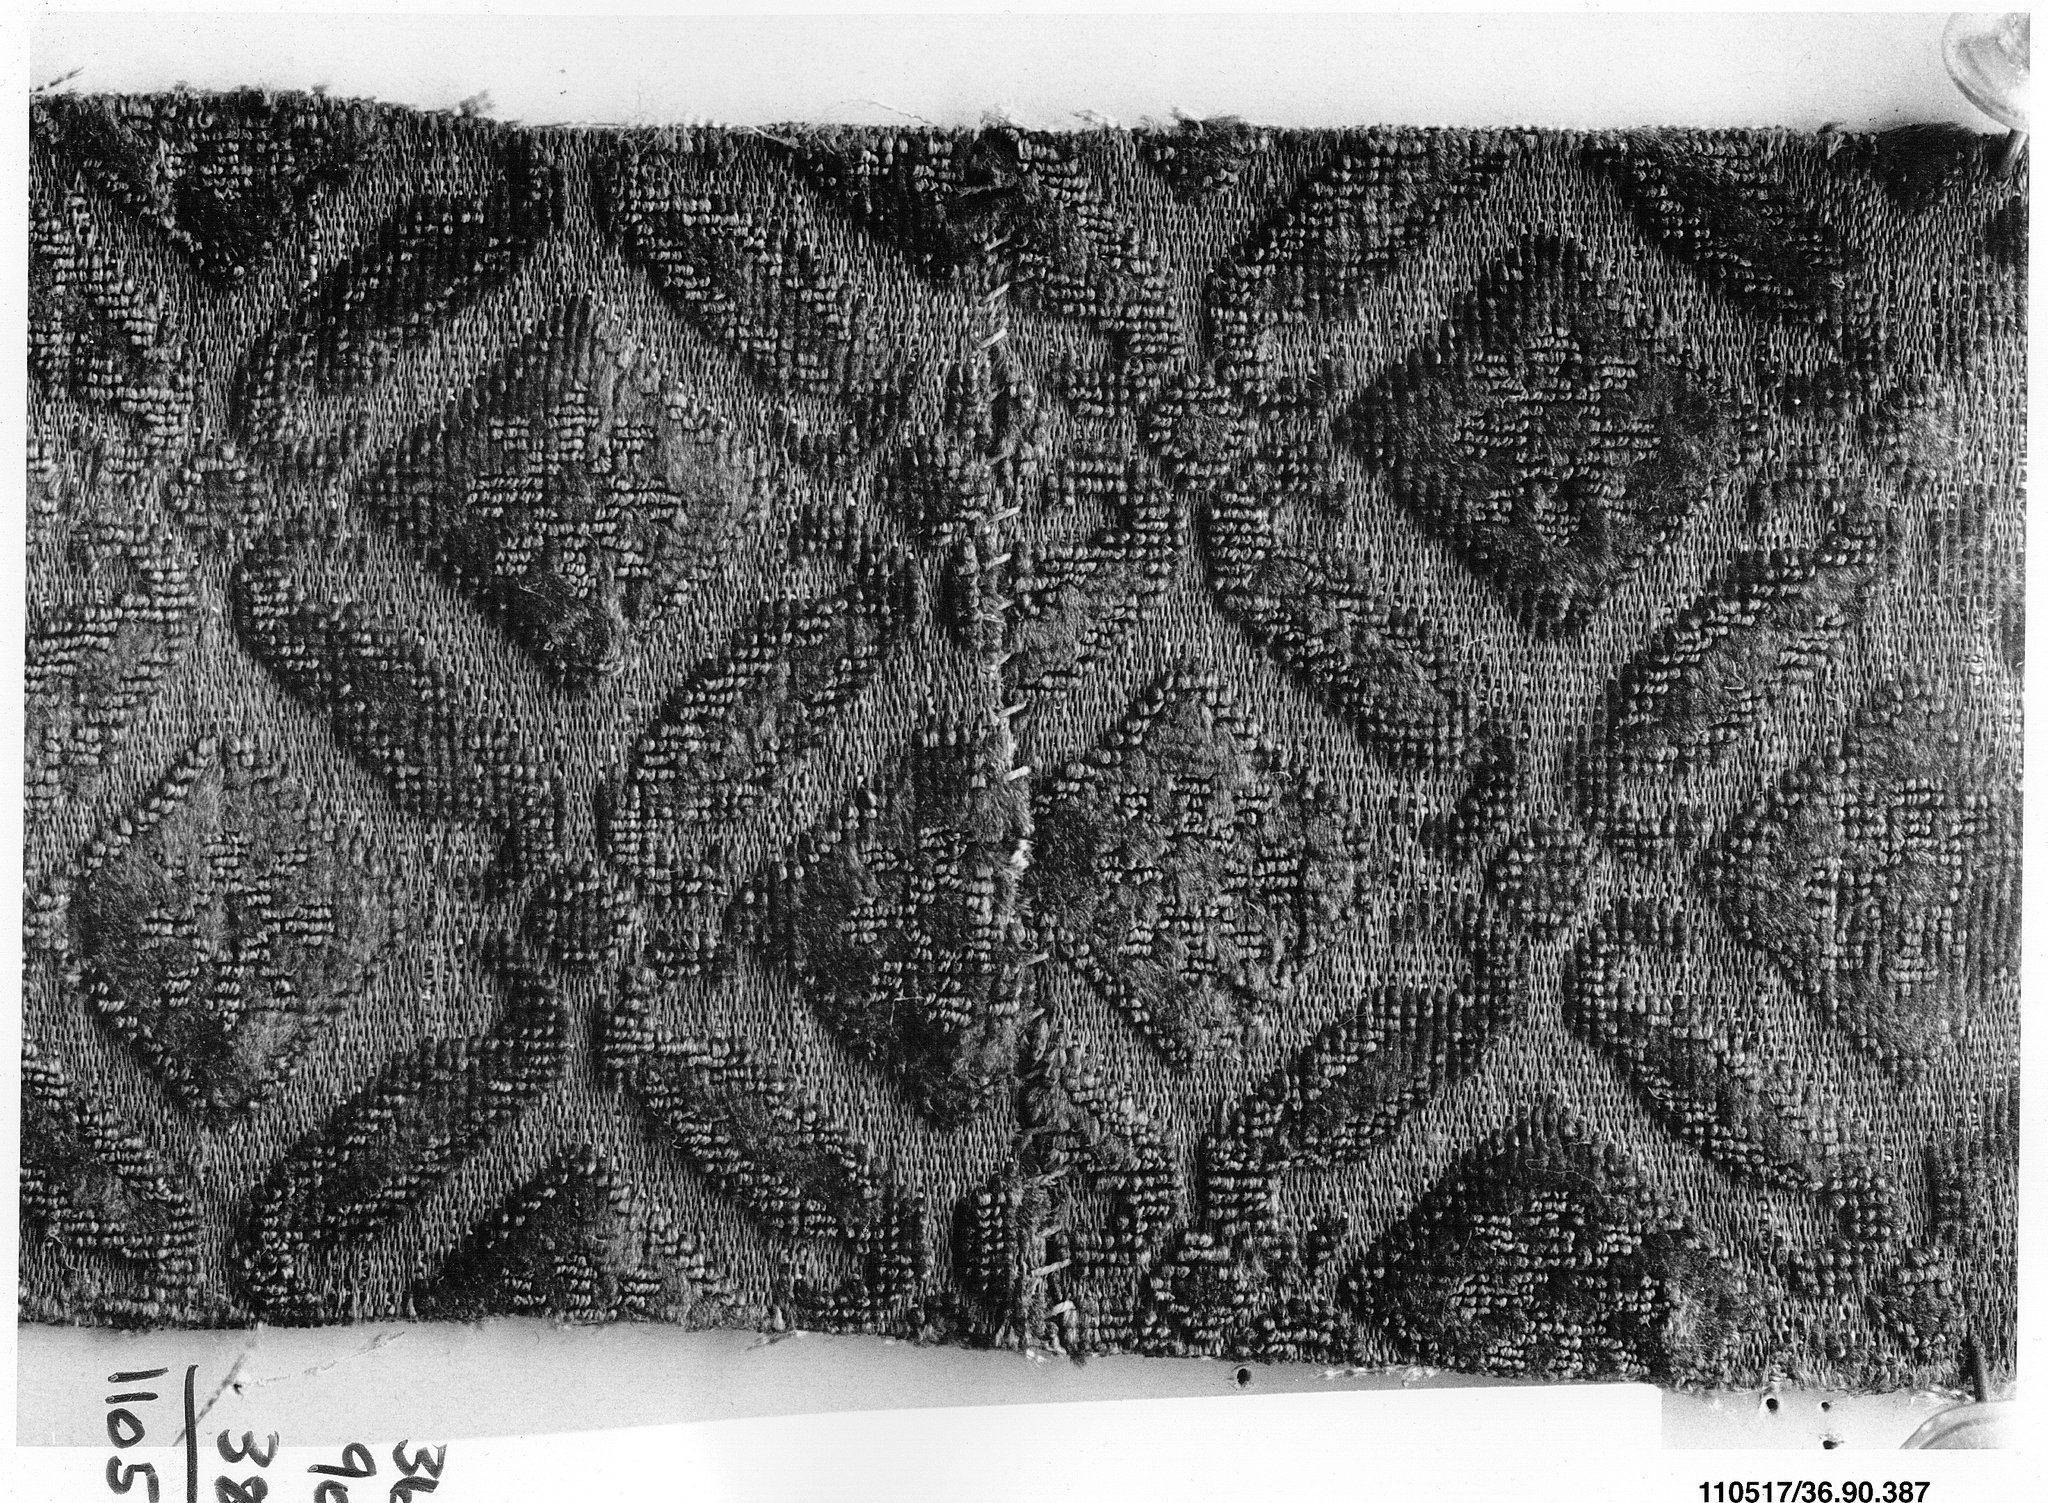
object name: piece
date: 1501-1700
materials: silk